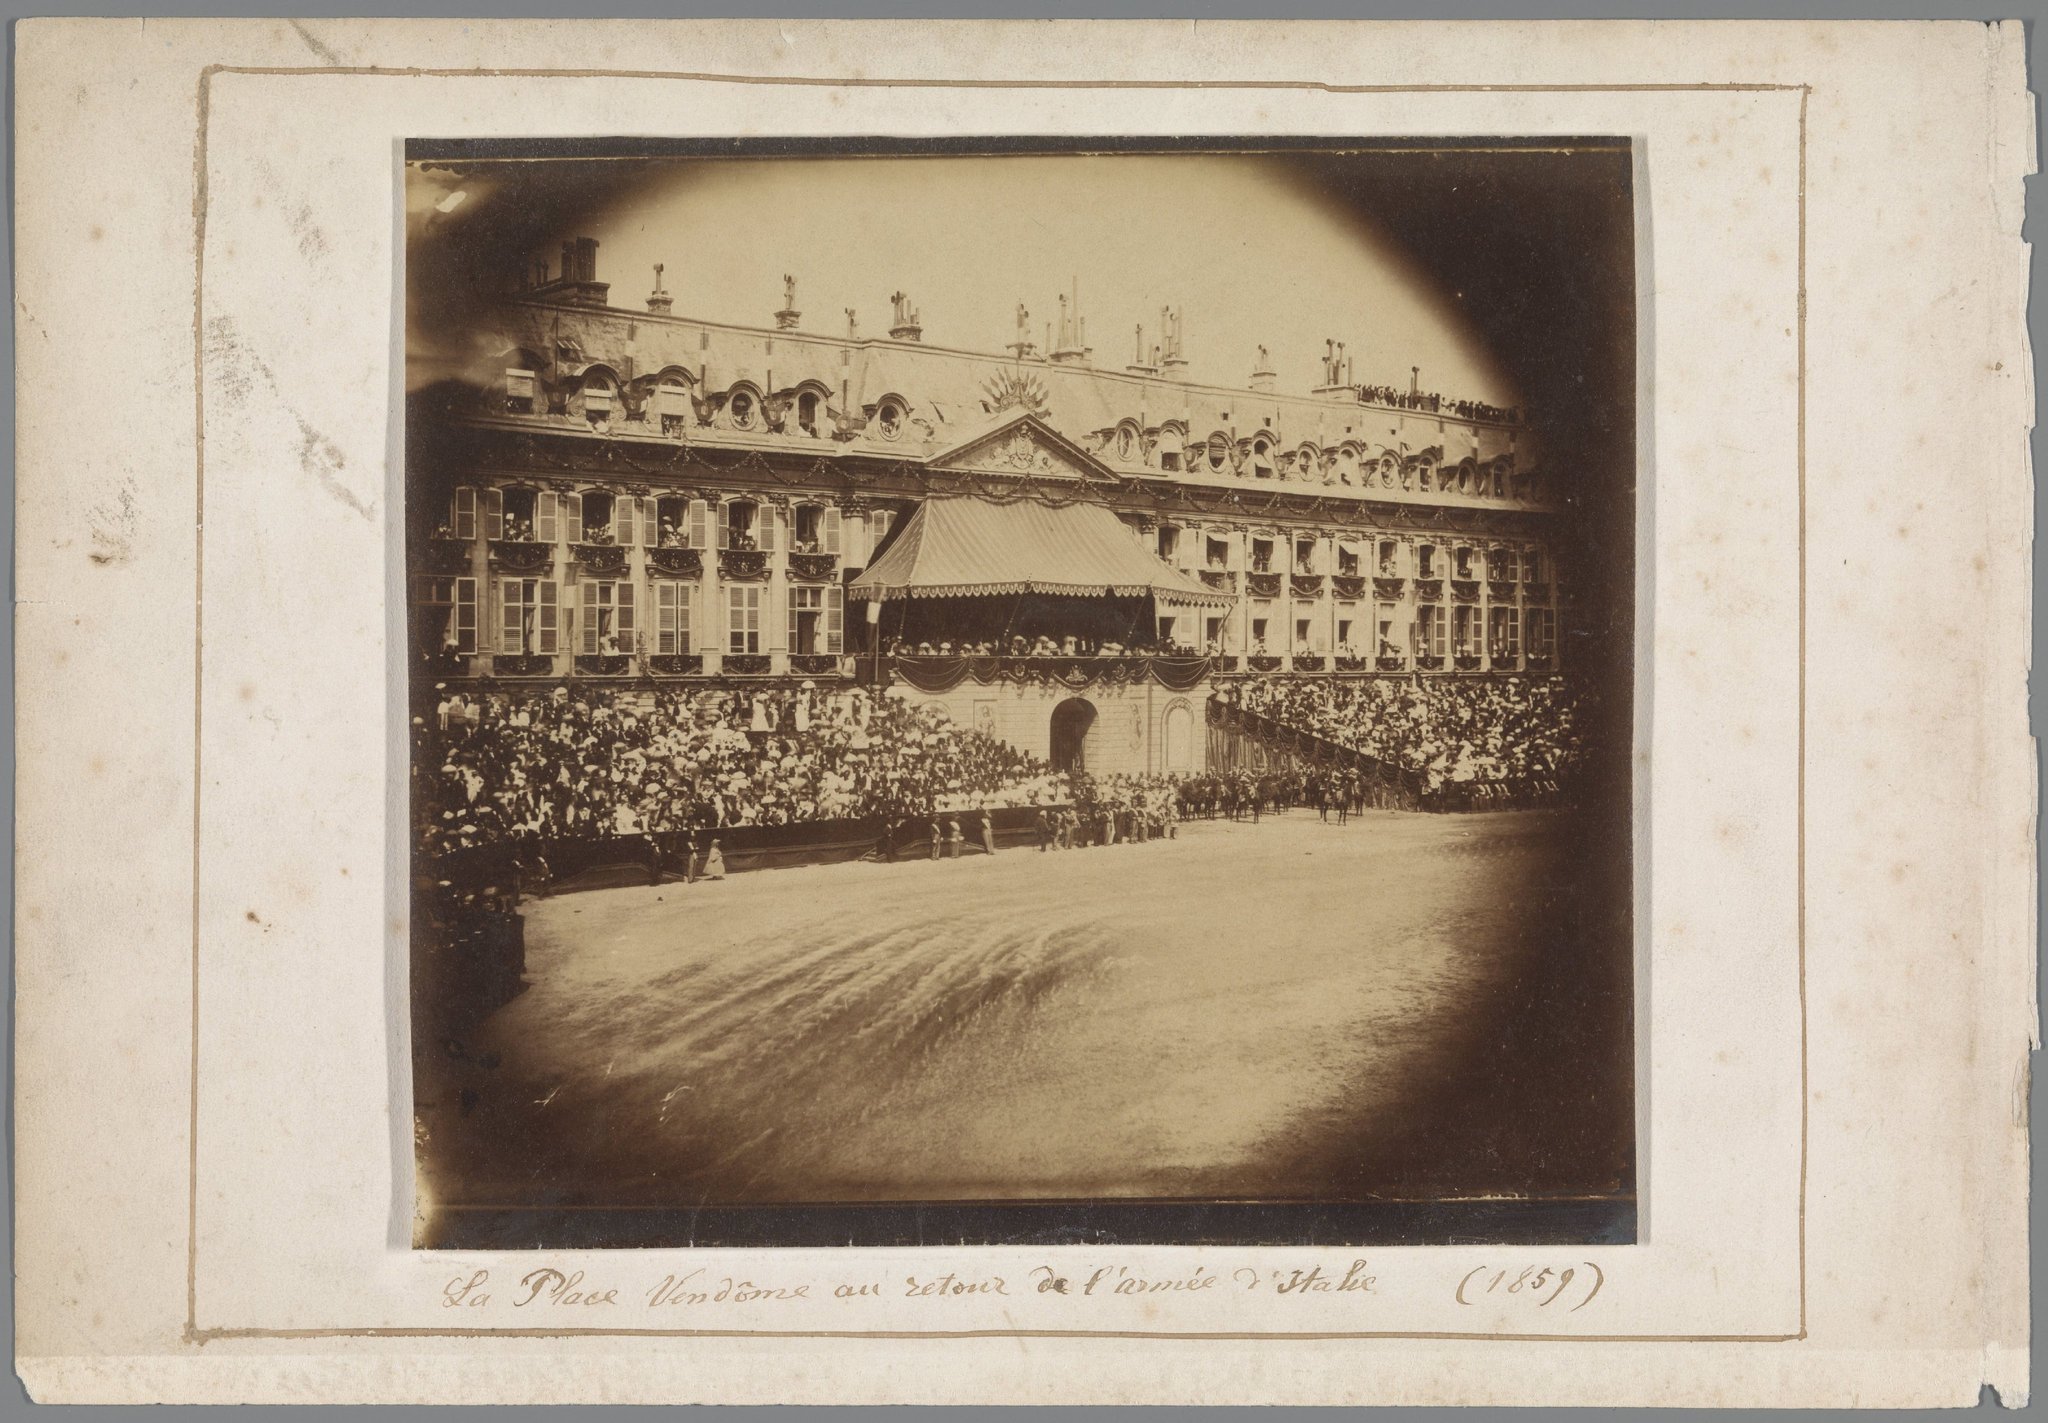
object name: photograph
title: Military Parade of the French Army on Place Vendôme, Paris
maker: félix nadar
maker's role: ballonvaarder, fotograaf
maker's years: 1820-1910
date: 1859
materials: paper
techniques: albumen print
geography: paris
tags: military parade, pageant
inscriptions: inscription: ‘La Place Vendome au retour de l'armée d'Italie (1859)’, inscription: ‘La Mer à Sainte Adresse (Manche)’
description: This early snapshot offers a quick impression of a military parade on Place Vendôme in Paris. The French army had just returned from a successful campaign against the Austrians in Italy. Press photography for newspapers and magazines did not yet exist in the 19th century. This photograph was published a week later in the magazine l’Illustration, but only after it had been copied and reworked as a wood engraving.